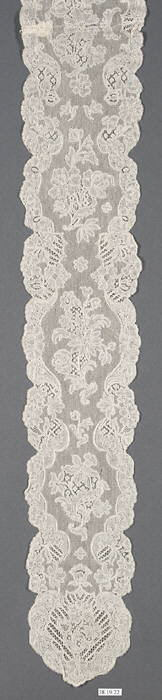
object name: lappet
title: Pair of lappets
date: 1701-1800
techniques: lace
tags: flowers